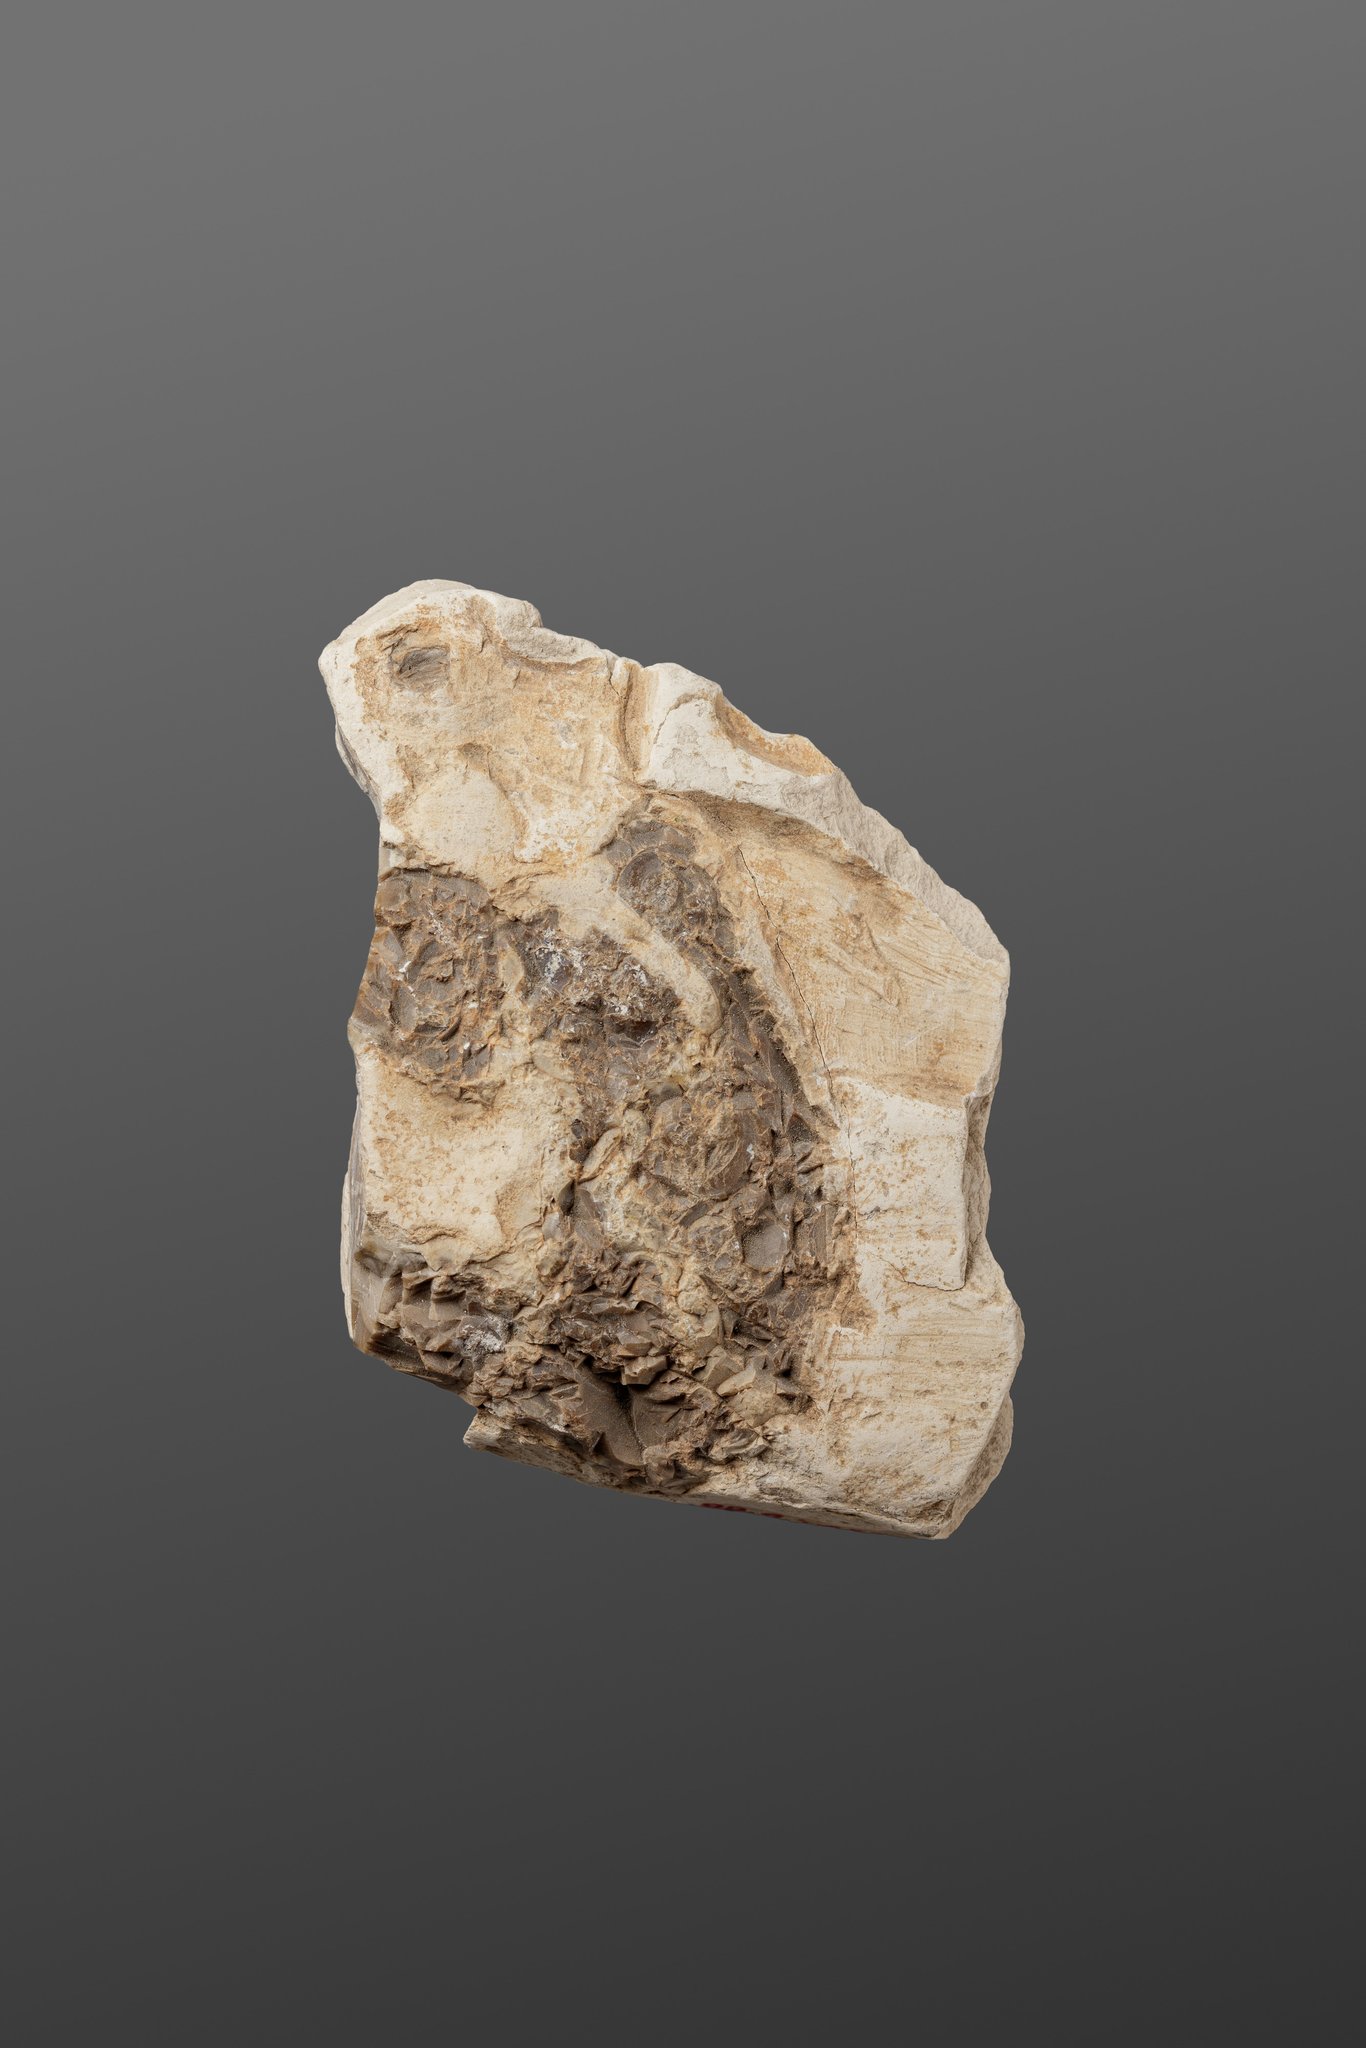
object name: relief fragment 47, tomb of mereri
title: Relief fragment possibly from the tomb of Mereri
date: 2100-2090 BCE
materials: stone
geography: egypt